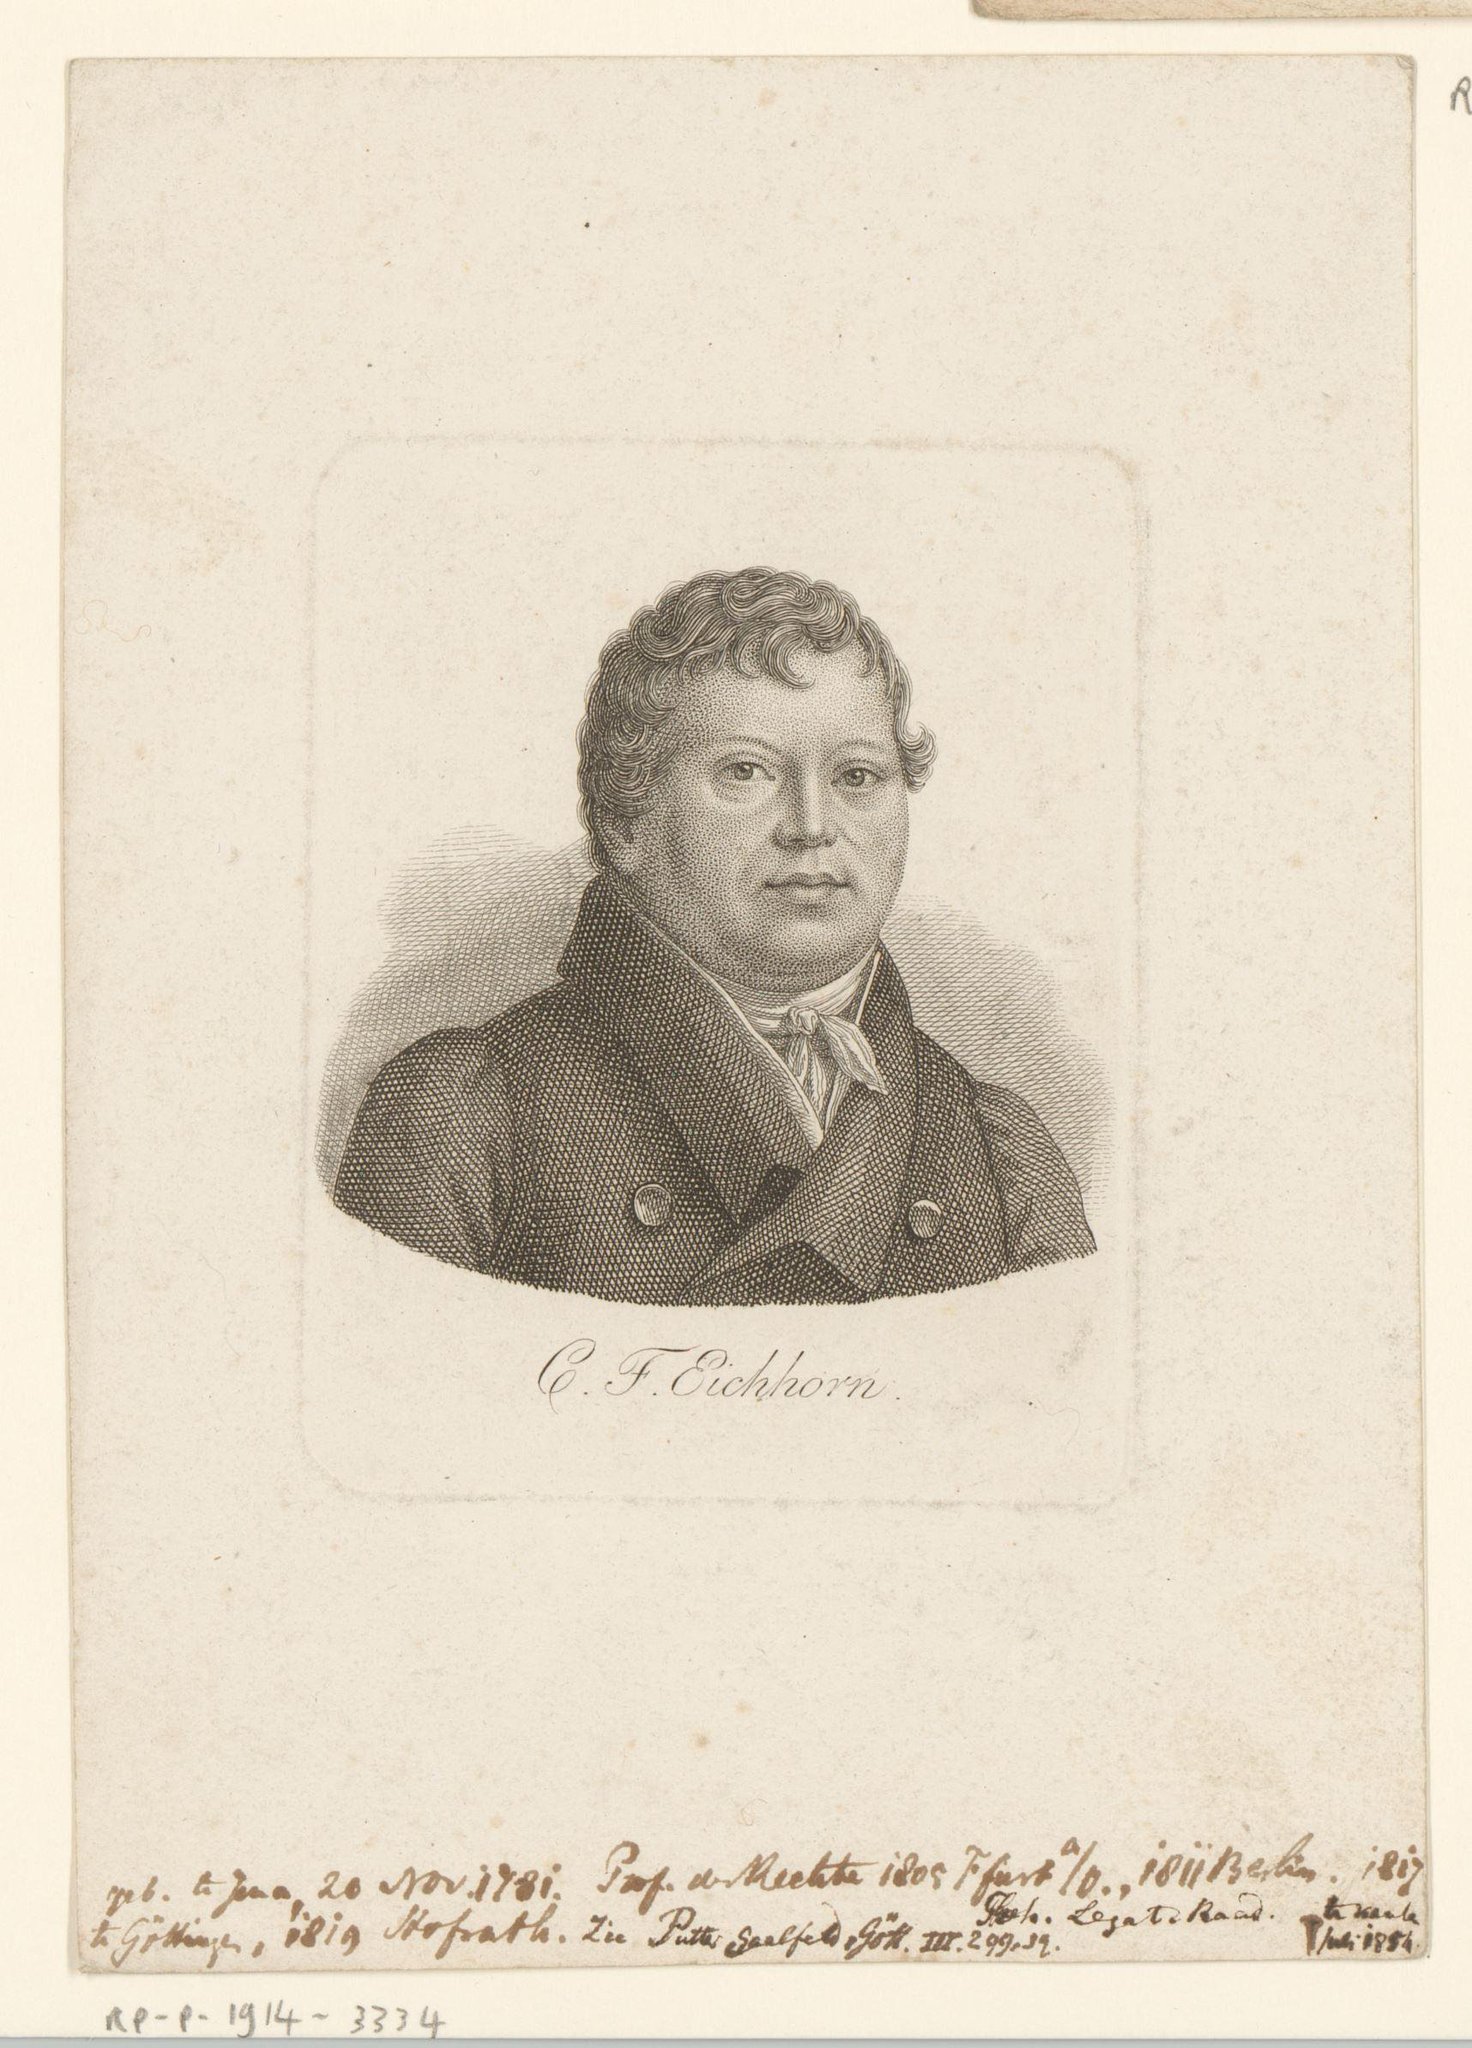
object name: print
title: Portret van Karl Friedrich Eichhorn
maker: ernst ludwig riepenhausen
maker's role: print maker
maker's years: 1765-1840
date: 1775-1840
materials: paper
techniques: engraving, etching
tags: historical persons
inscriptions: collector's mark: Lugt 2228